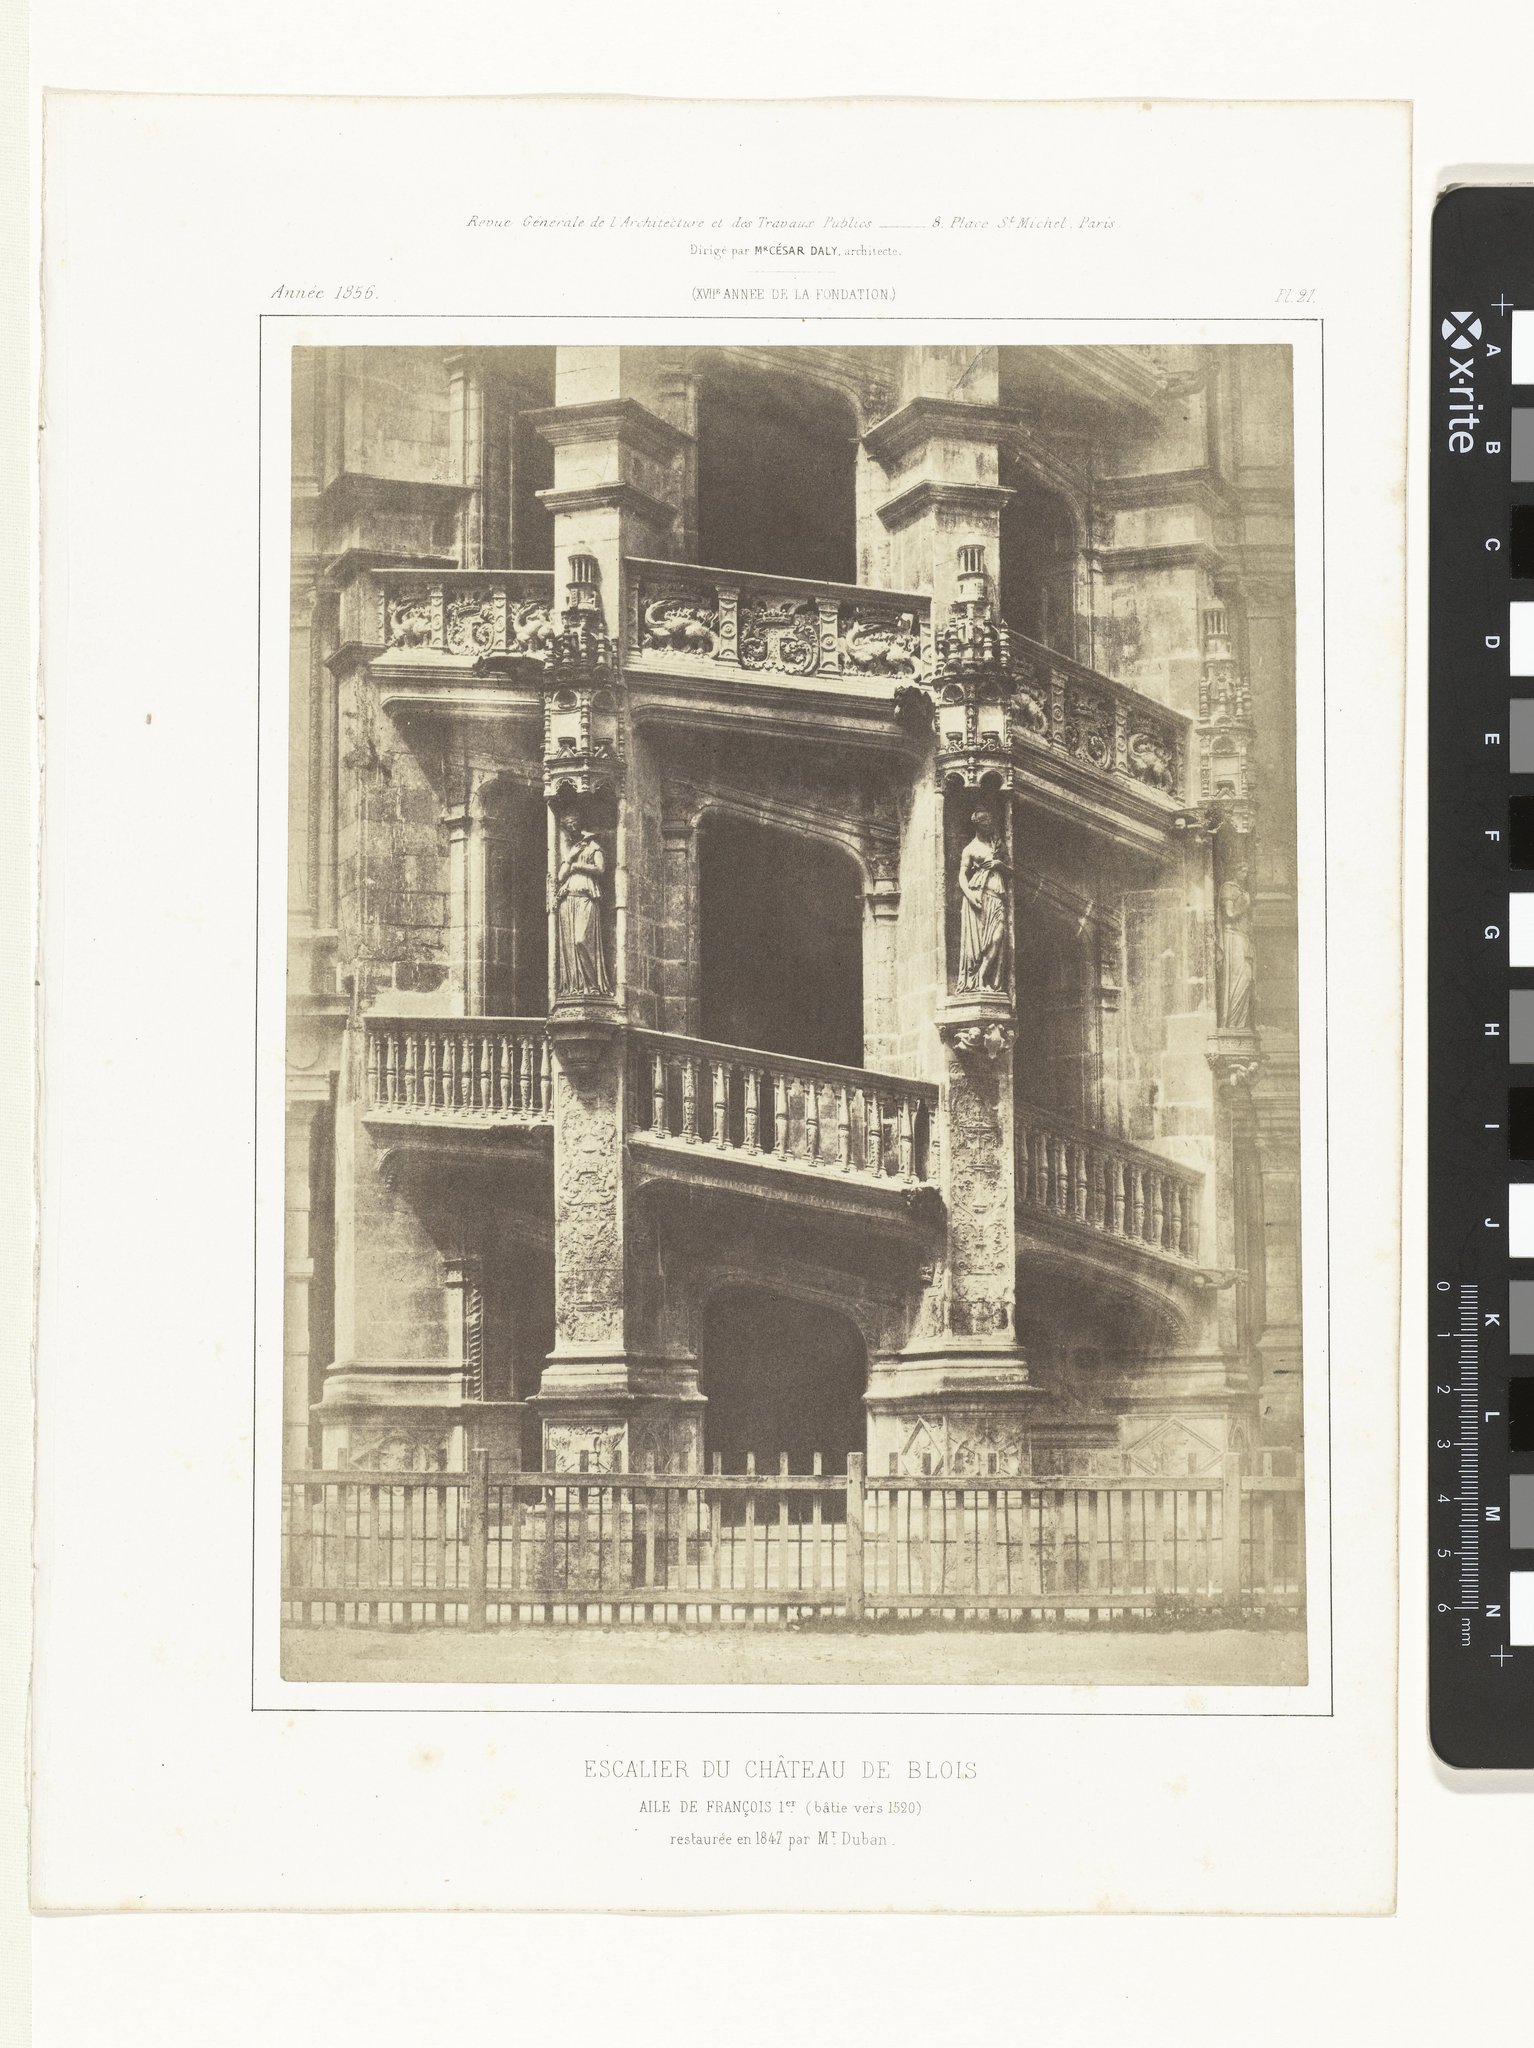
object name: photograph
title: Gedraaide trap van het kasteel van Blois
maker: françois alphonse fortier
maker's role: fotograaf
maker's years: 1825-1882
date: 1855-1856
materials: paper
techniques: salted paper print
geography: blois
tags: staircase, façade (of house or building)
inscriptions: inscription: ‘Revue Générale de l'Architecture et des Travaux Publics - 8, Place St. Michel, Paris/ Dirigé par Mr César Daly, architecte./ Année 1856 (XVIIe année de la fondation.) Pl. 21./ Escalier du Château de Blois/ Aile de François Ier (bâtie vers 1520)/ restaurée en 1847 par Mr Duban.’